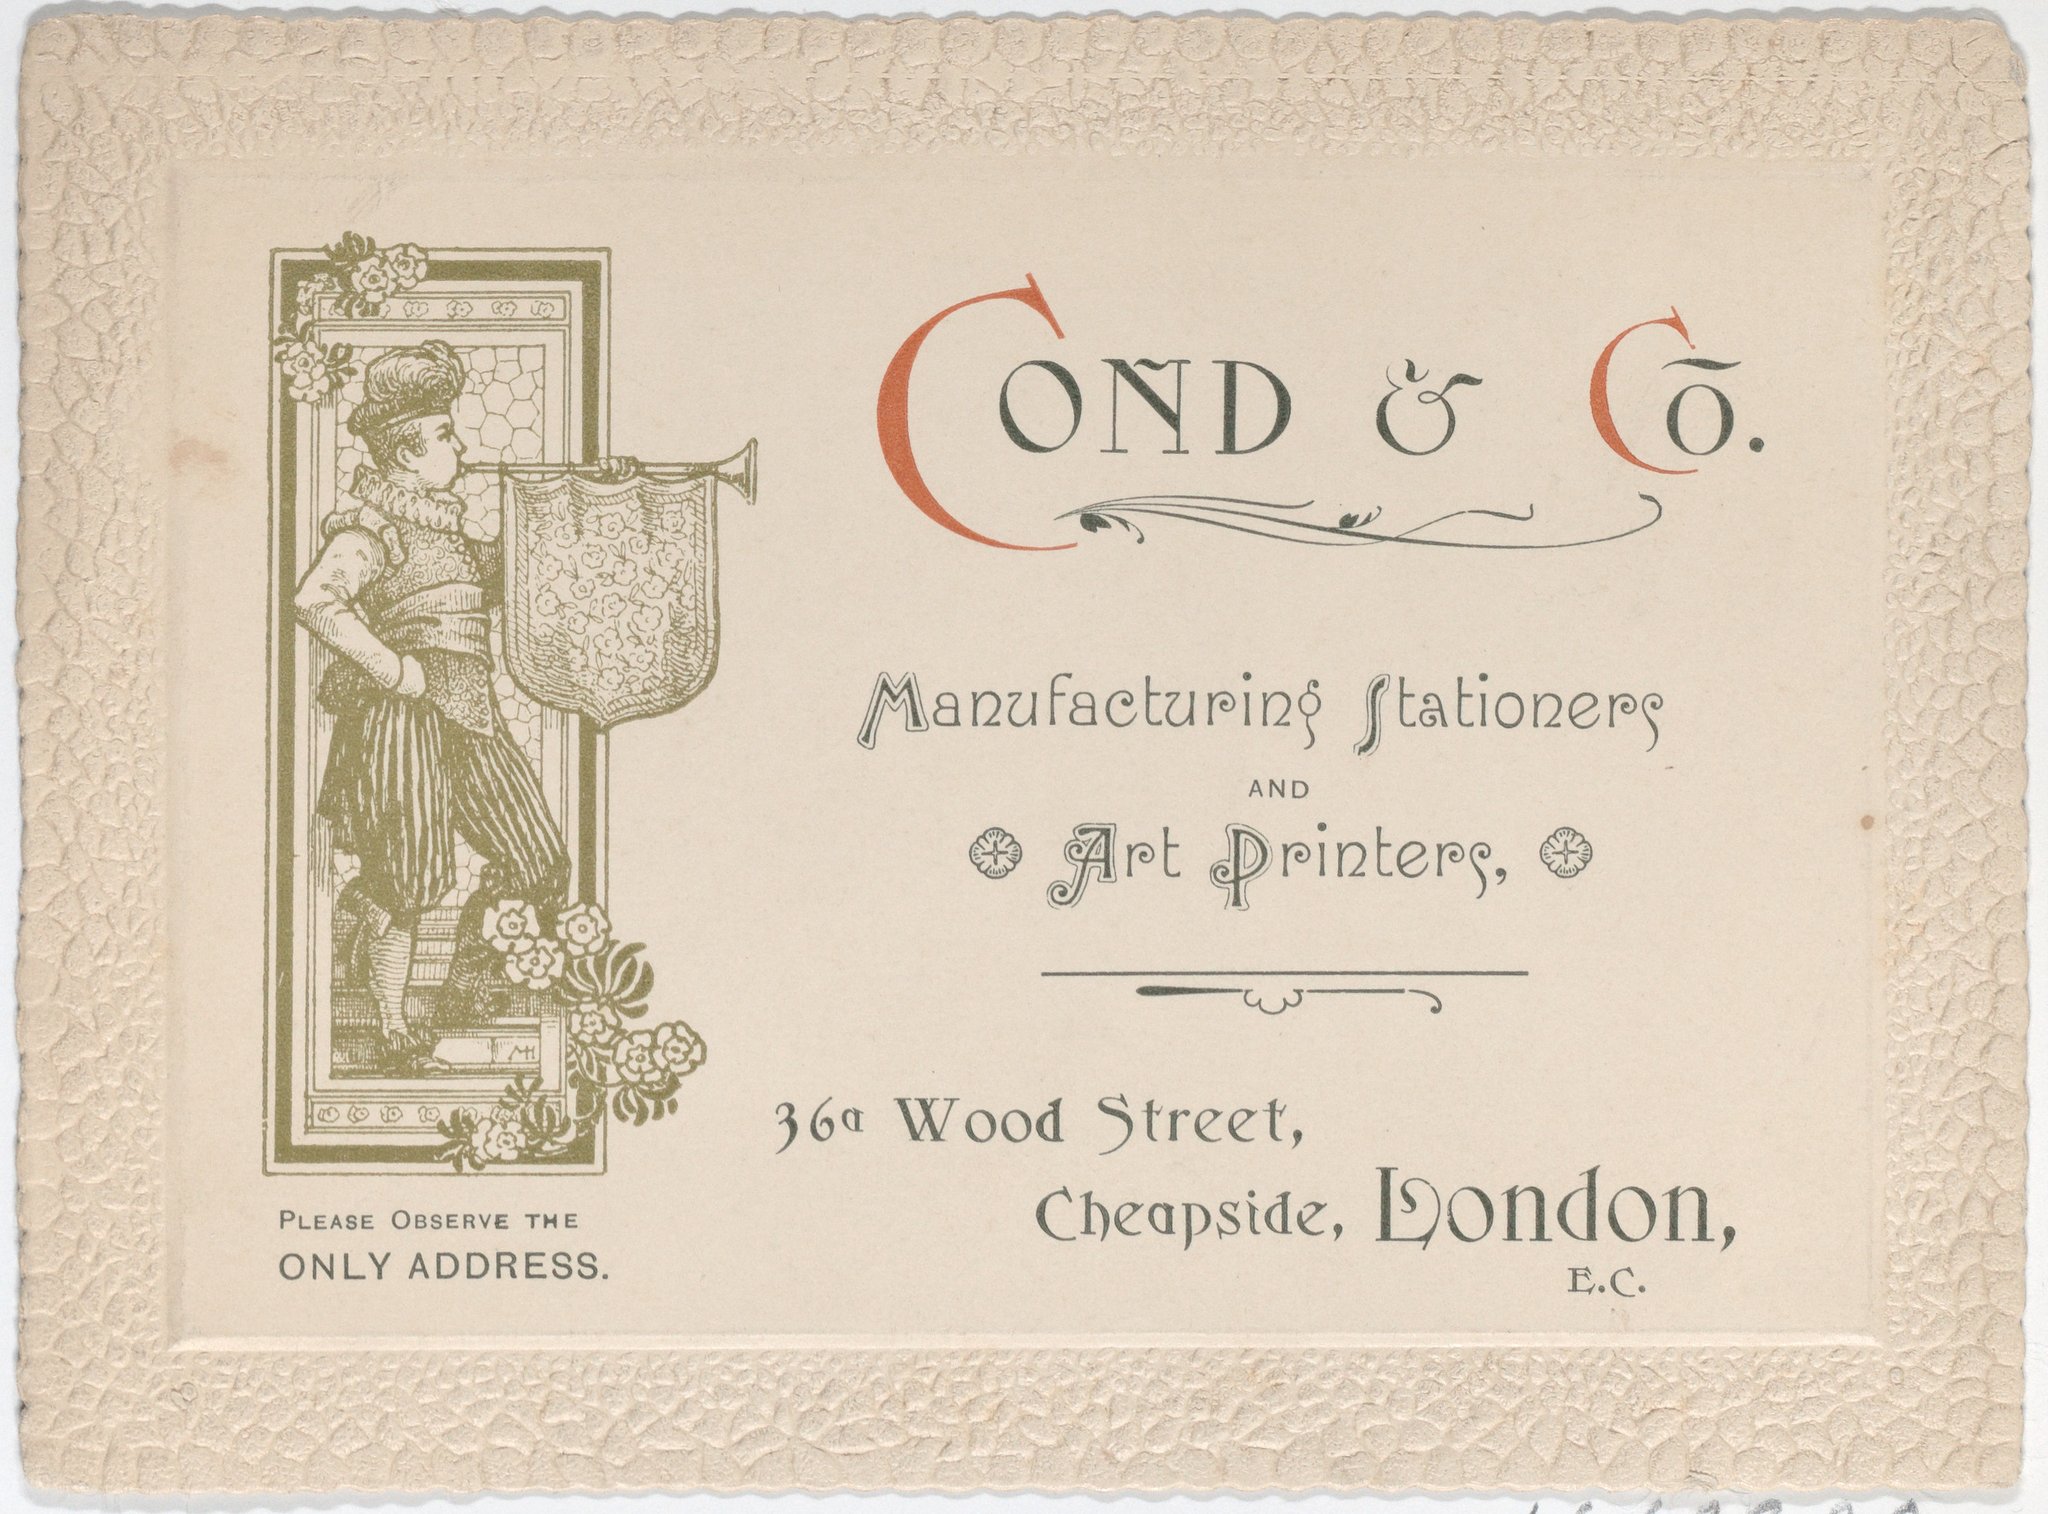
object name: print, trade card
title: Trade Card for Cond & Co., Manufacturing Stationers and Art Printers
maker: anonymous, british, 19th century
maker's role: artist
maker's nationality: british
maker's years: 1800-1900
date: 1801-1900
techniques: lithography